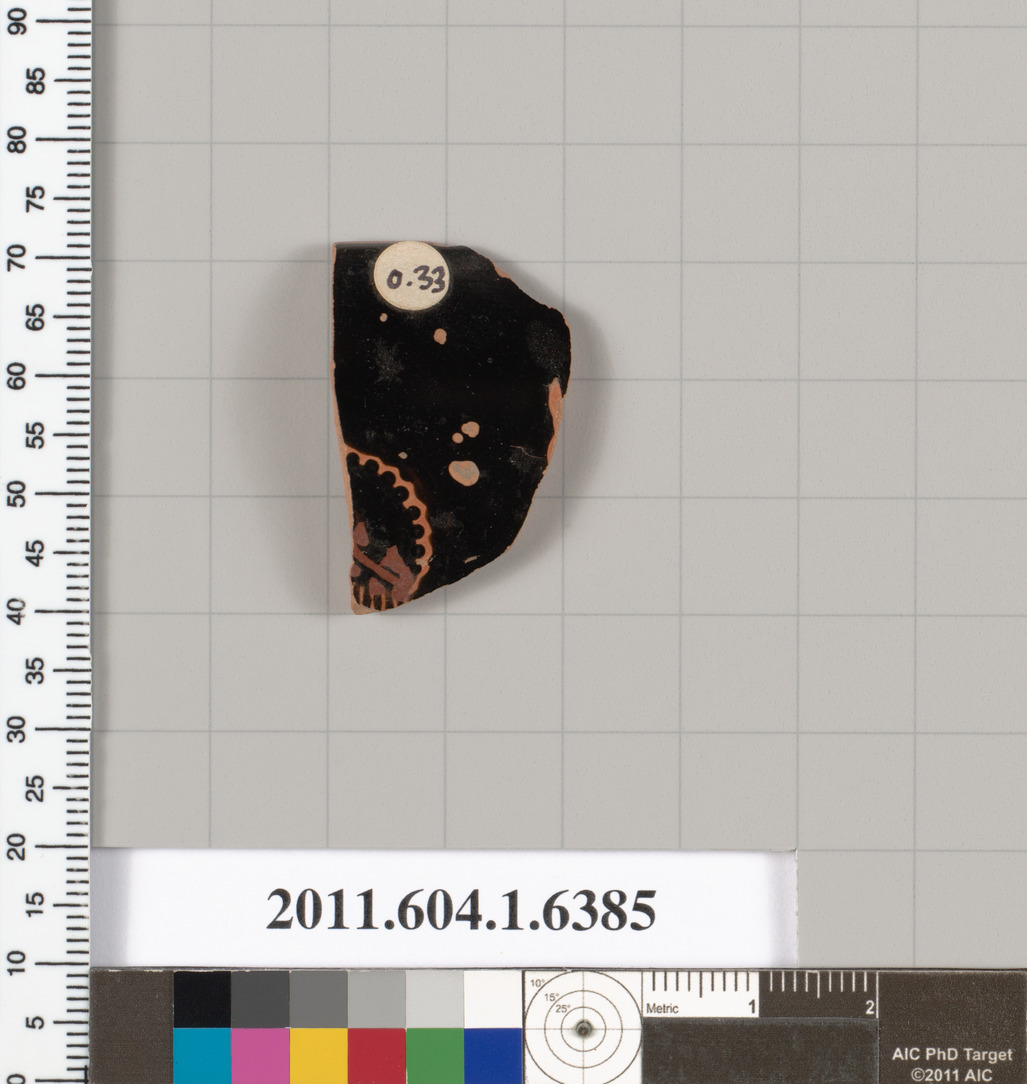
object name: kylix fragment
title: Terracotta rim fragment of a kylix (drinking cup)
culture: greek, attic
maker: antiphon painter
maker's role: artist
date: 490-480 BCE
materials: terracotta